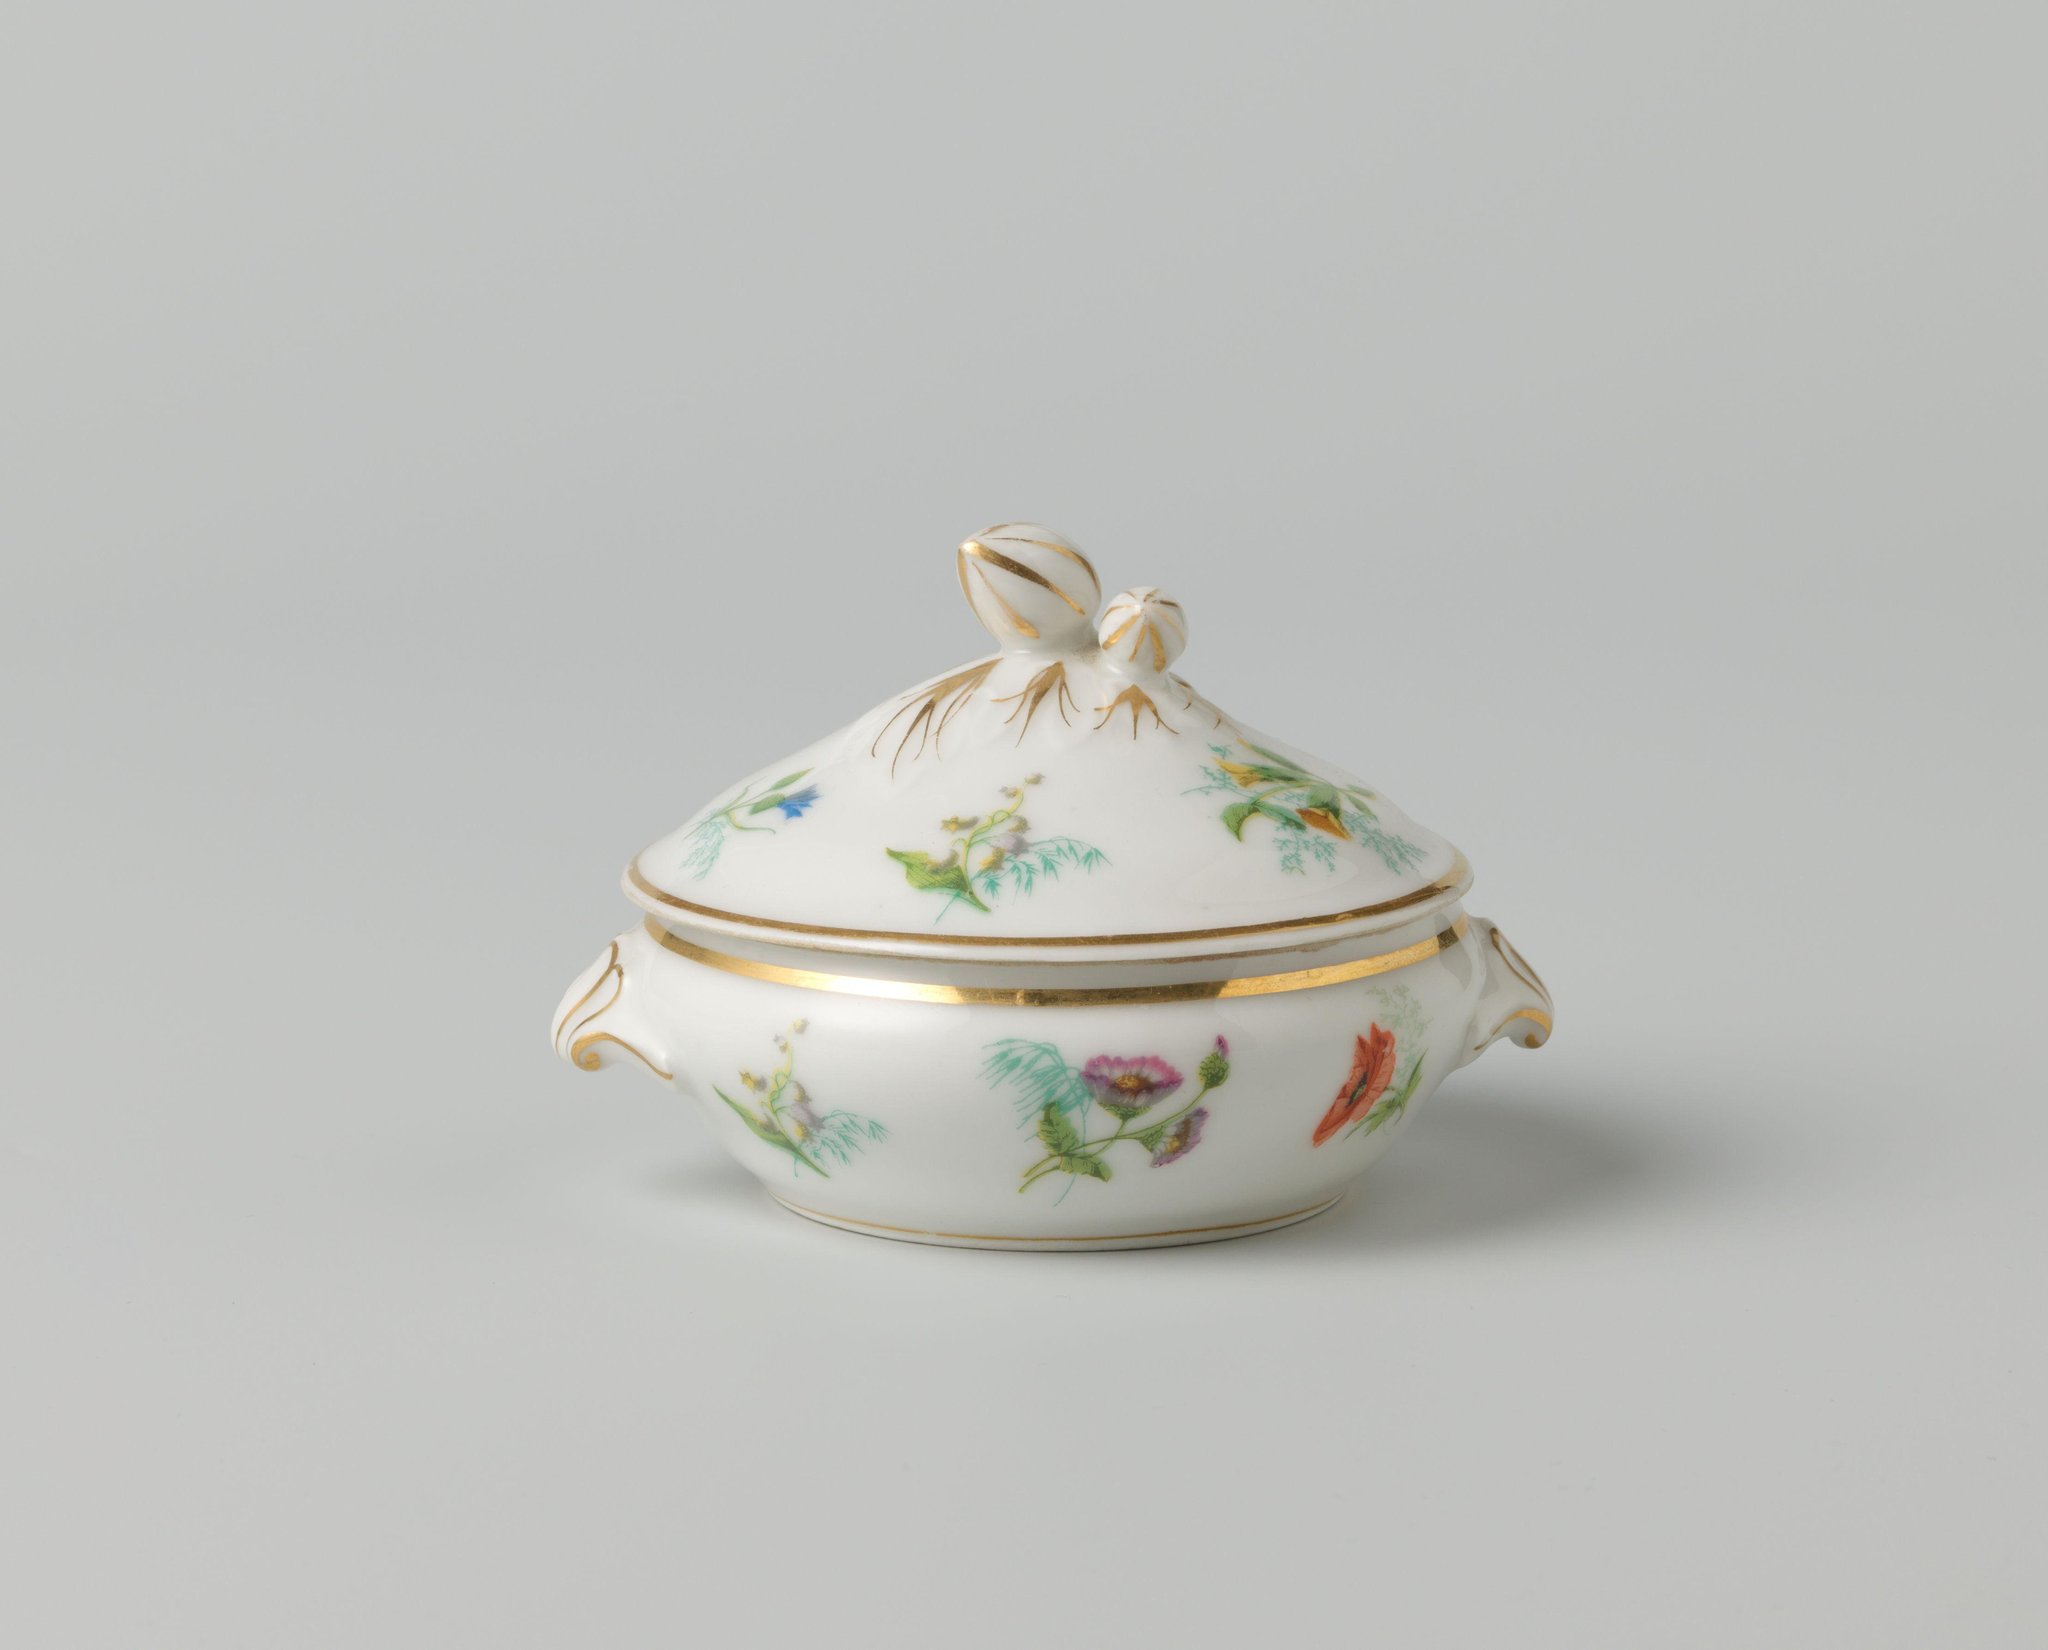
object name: toy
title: Cover of tureen with various flower sprays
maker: Anonymous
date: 1850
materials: glaze, gold, paint, porcelain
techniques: firing, forming, gilding, turning, vitrification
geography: france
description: Deksel van een terrine van porselein, versierd op het glazuur met blauw, rood, roze, groen, geel, paars en goud. Met verschillende bloemtakken en gouden lijnen op de rand en knop. Dekselknop in de vorm van een bloemtak met twee knoppen op een gemodelleerd blad.